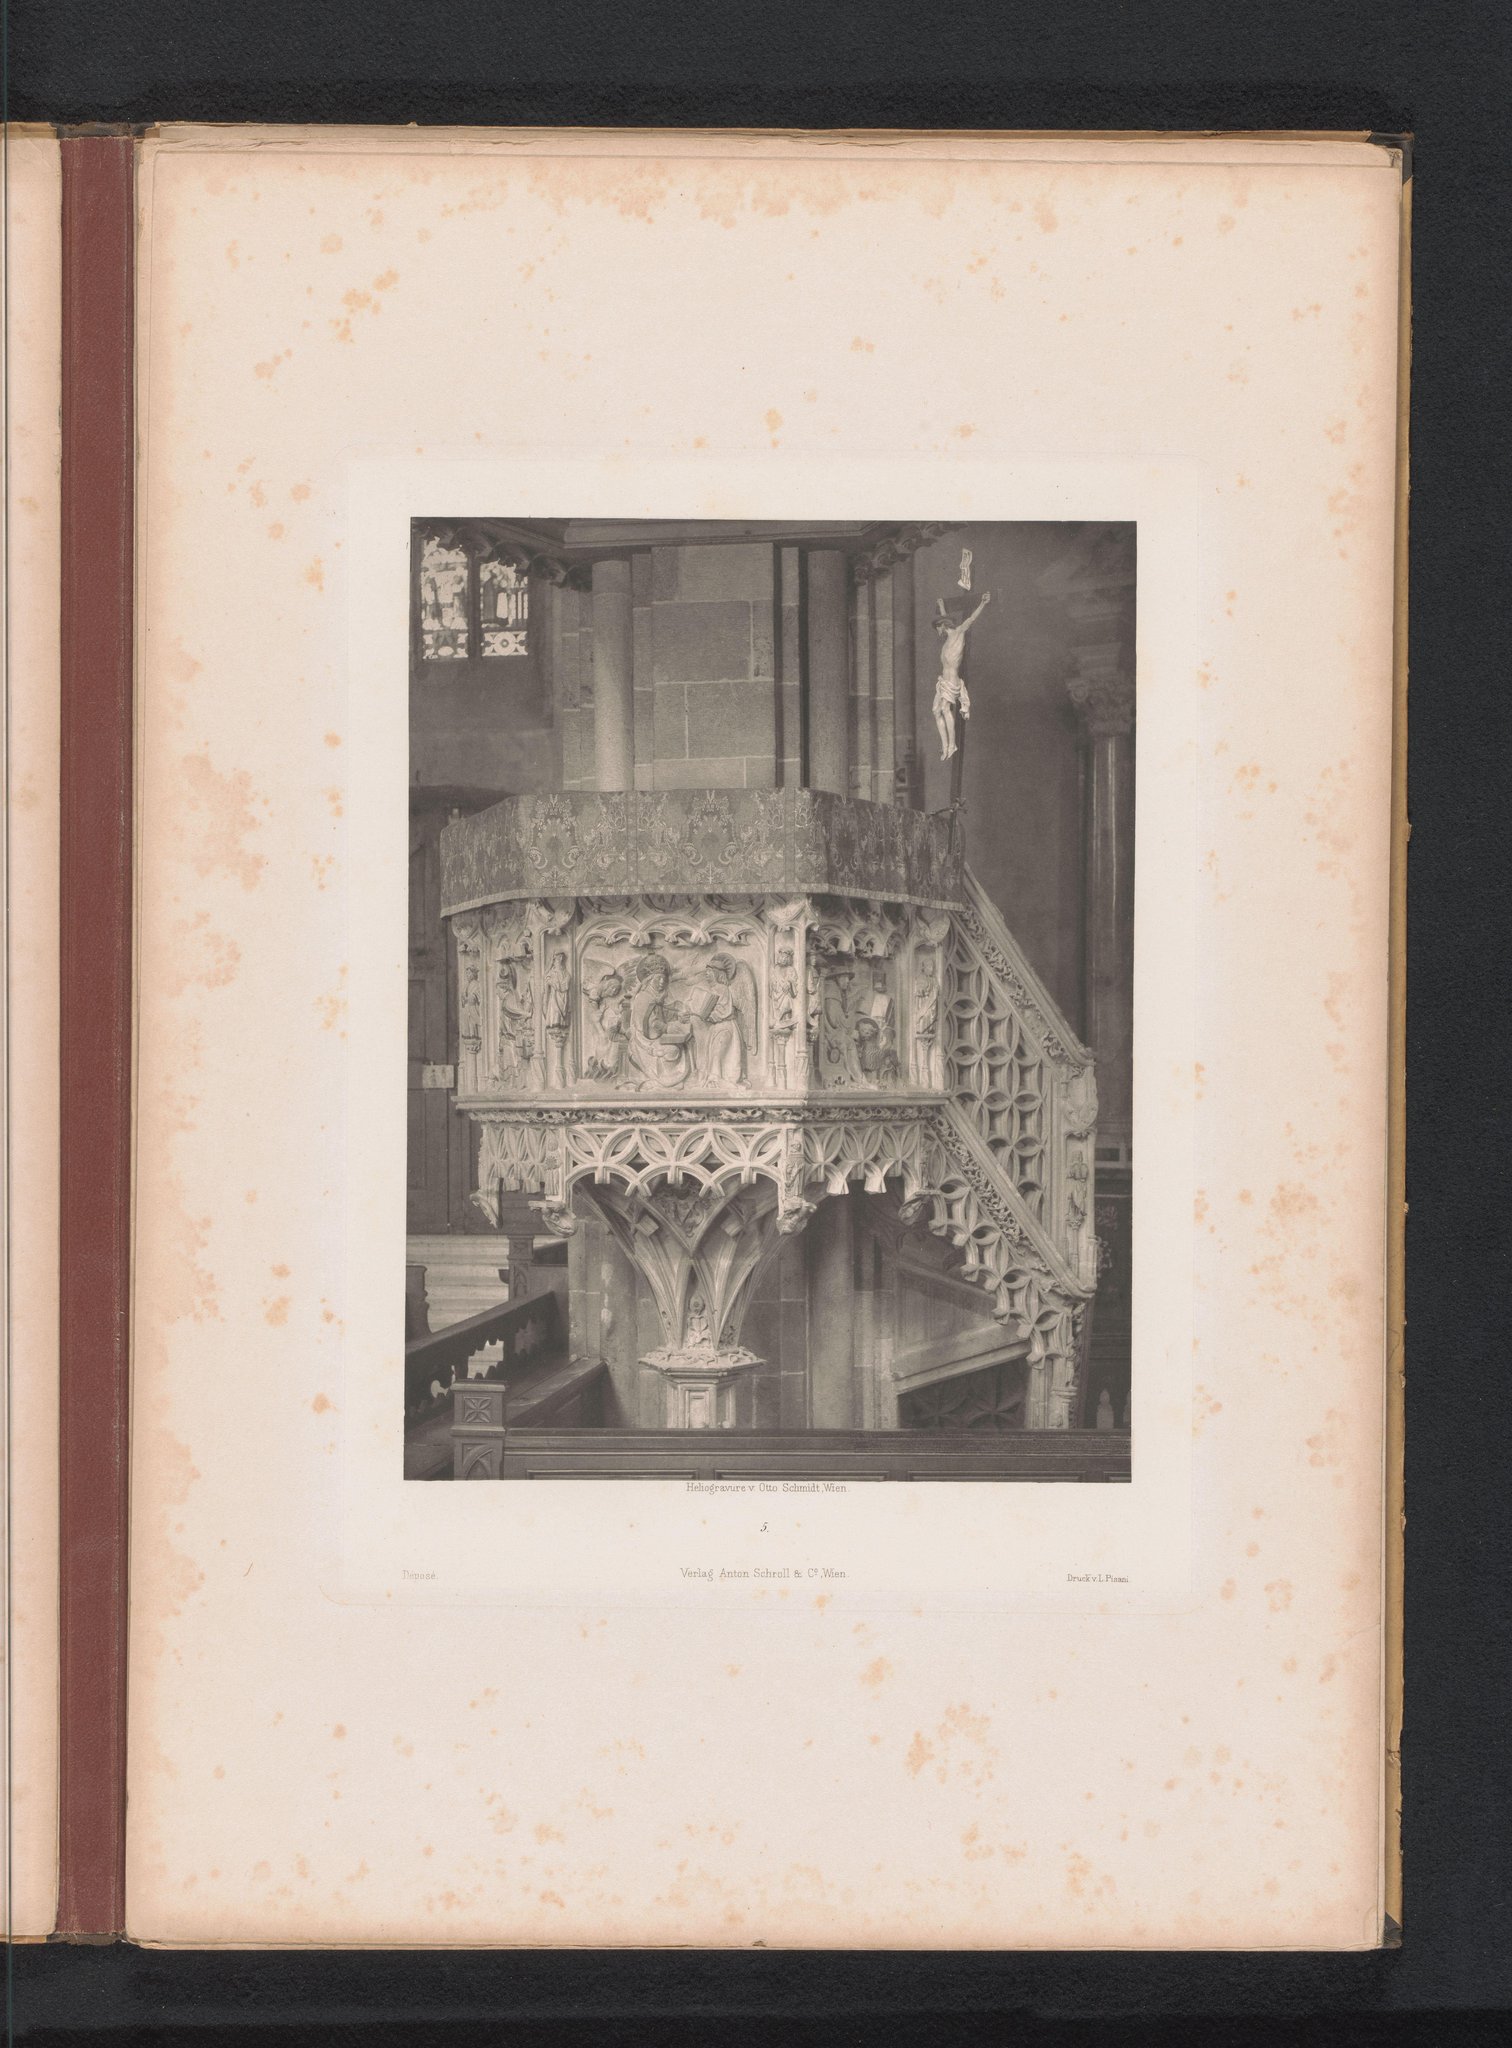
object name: photomechanical print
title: Kansel in de parochiekerk van Bolzano, Italië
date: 1888-1893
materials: paper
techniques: photoaquatint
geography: vienna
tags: pulpit, ambo, chancel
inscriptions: inscription: ‘Déposé.’, number: ‘5.’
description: Deze prent maakt deel uit van een omslag met twintig prenten, twee tekstbladen en een titelpagina.